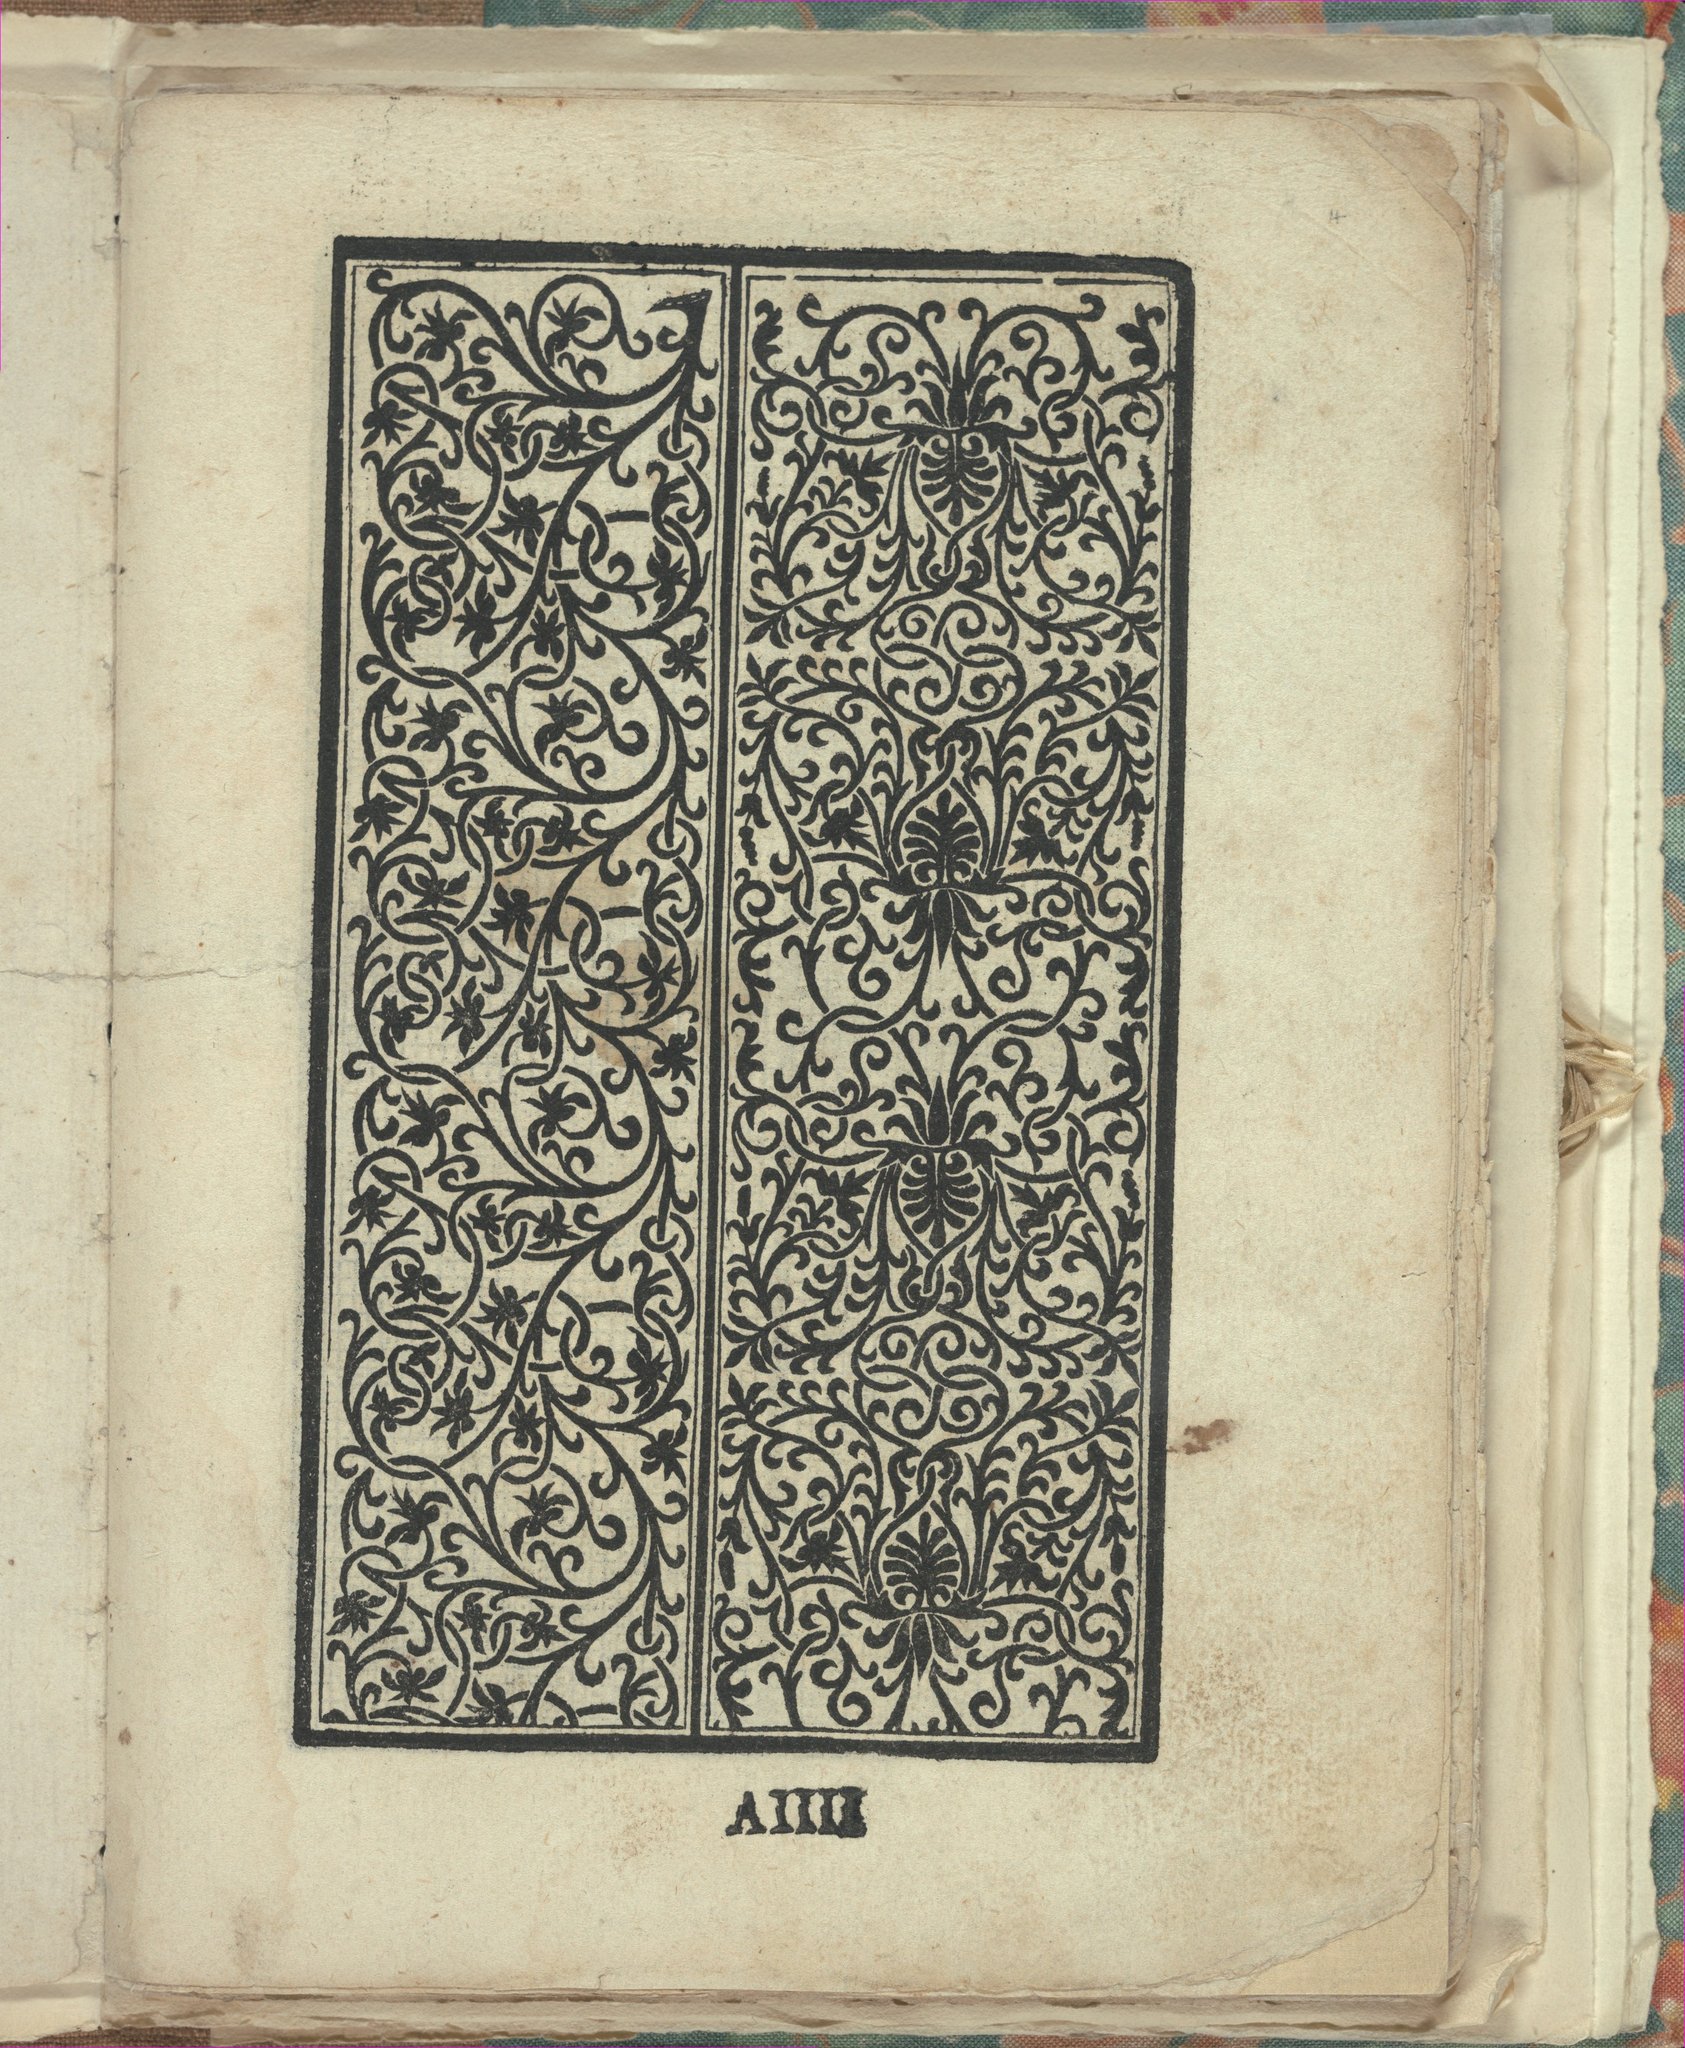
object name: book print ornament architecture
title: Opera Nova Universali intitulata Corona di racammi, page 4 (recto)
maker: giovanni andrea vavassore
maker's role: publisher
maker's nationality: italian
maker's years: 1530-1573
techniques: woodcut